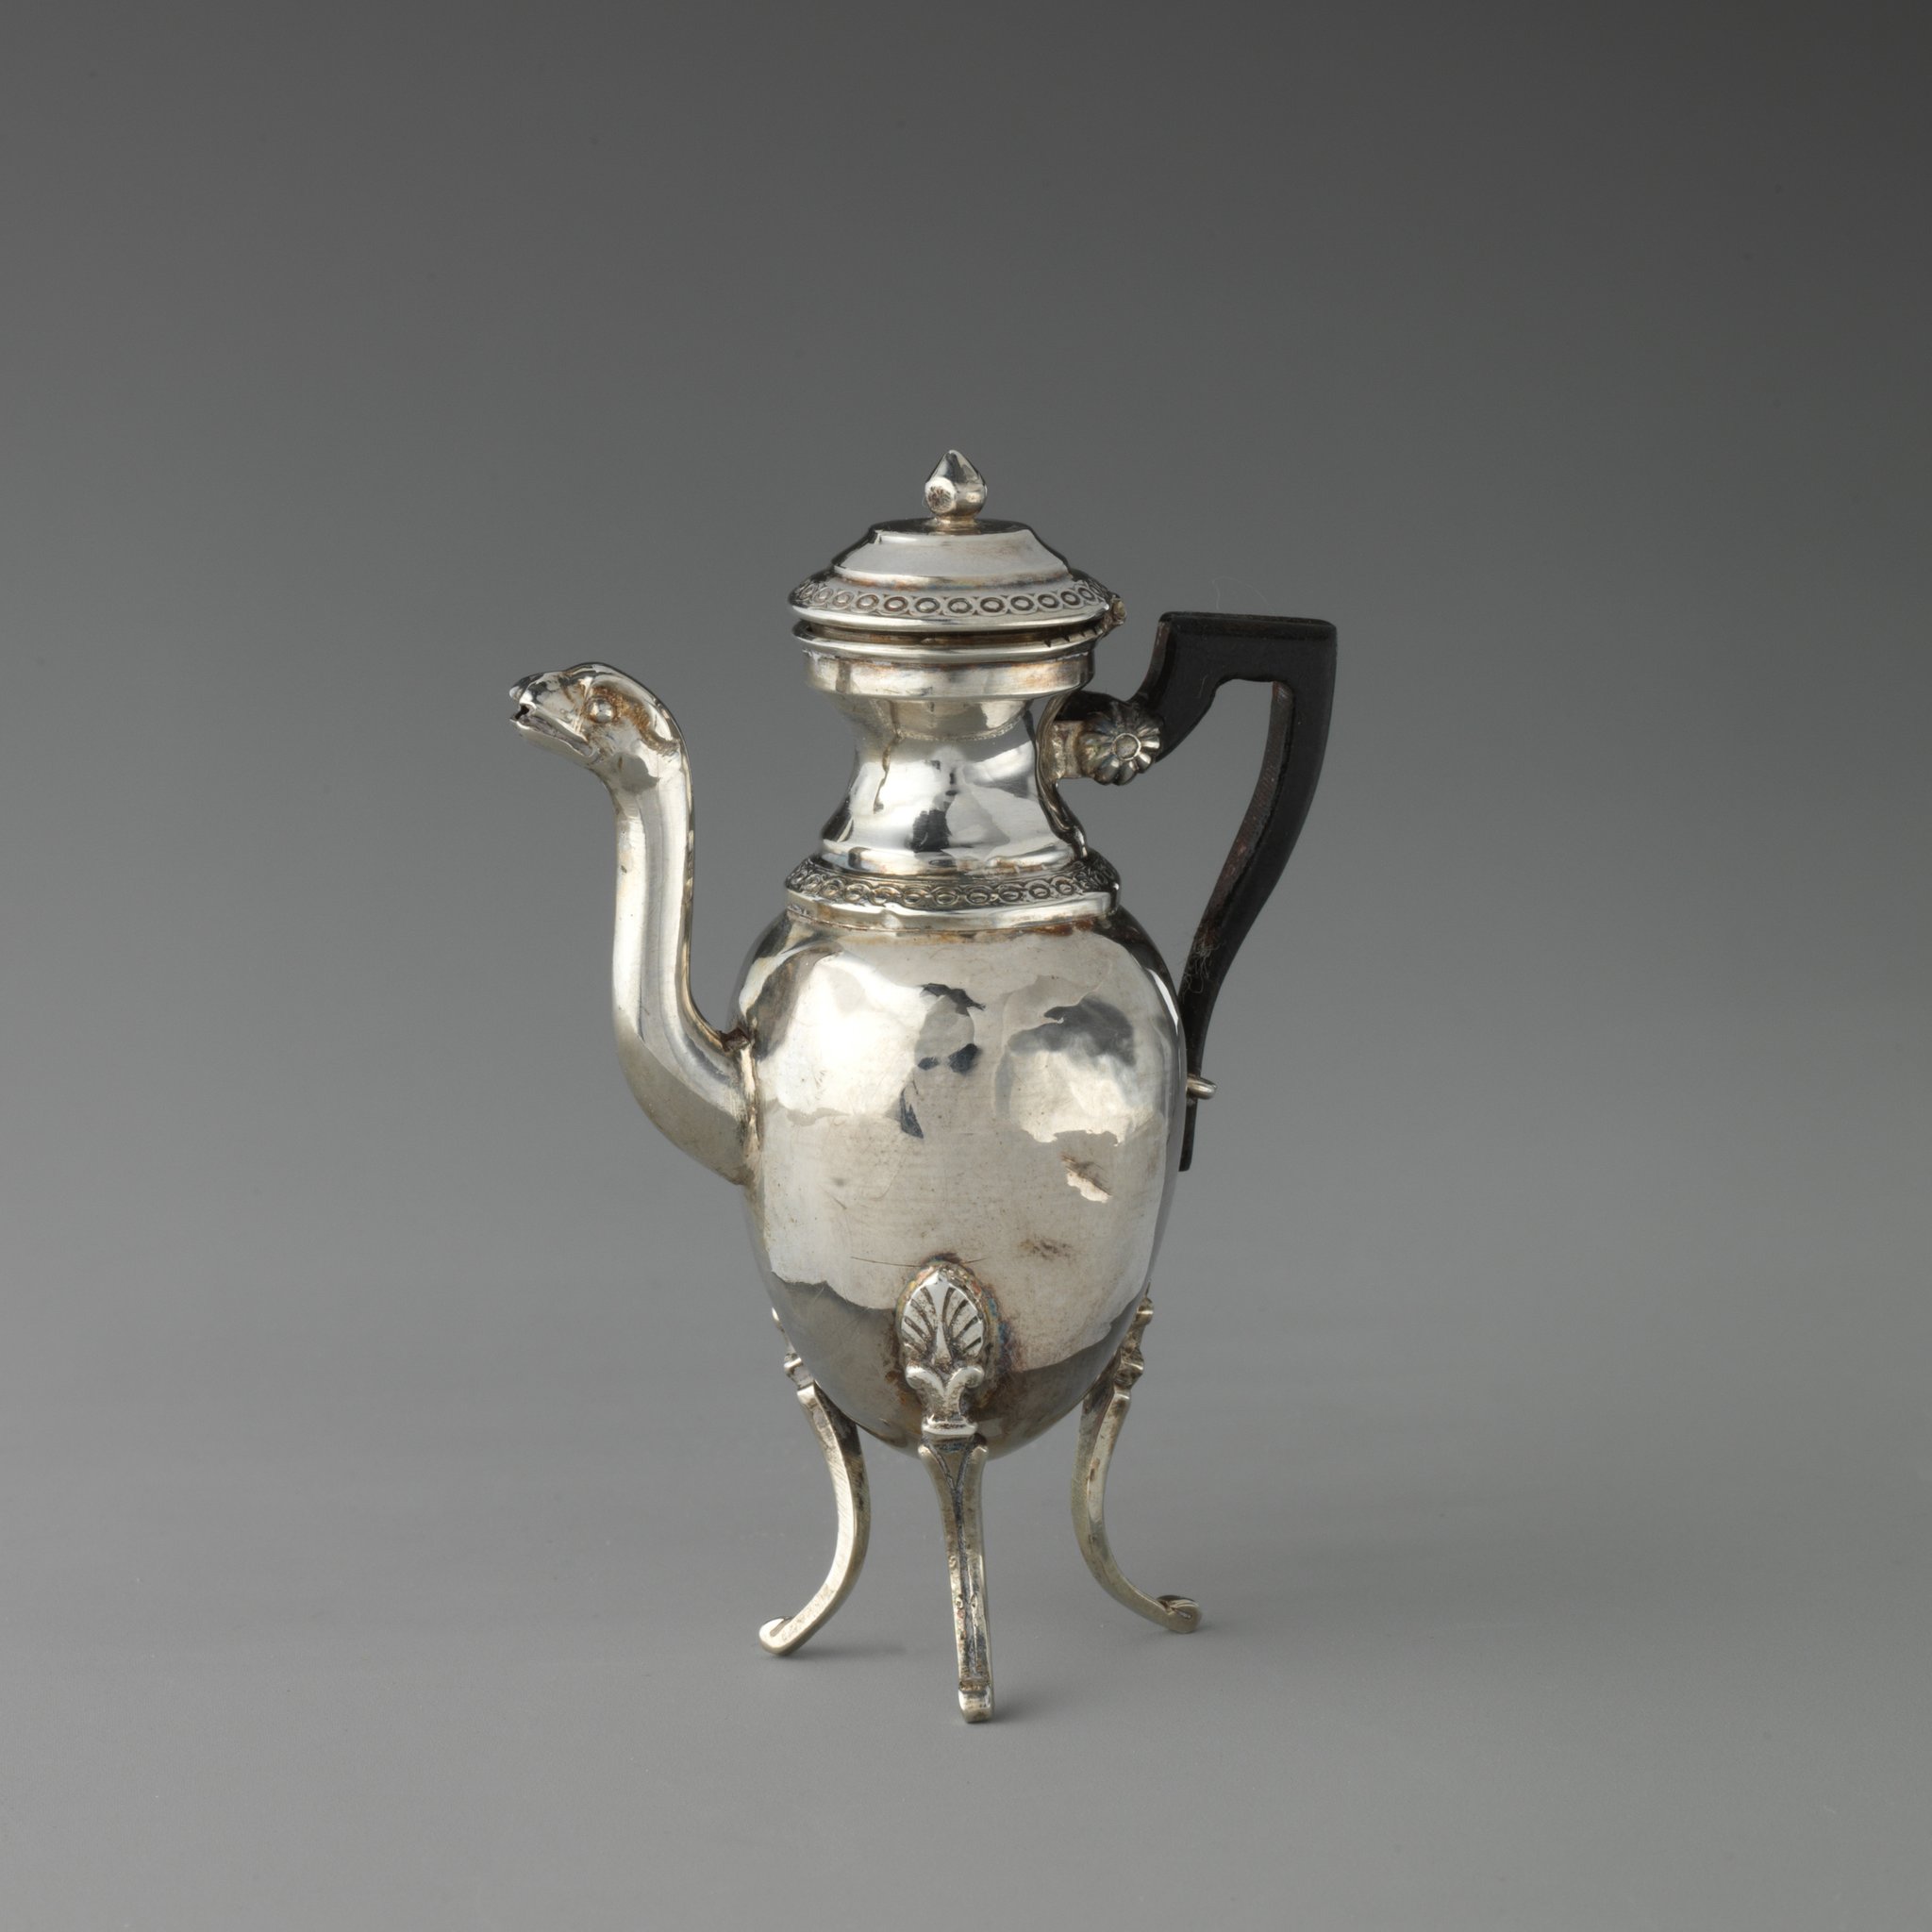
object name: coffeepot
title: Miniature coffeepot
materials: silver, wood